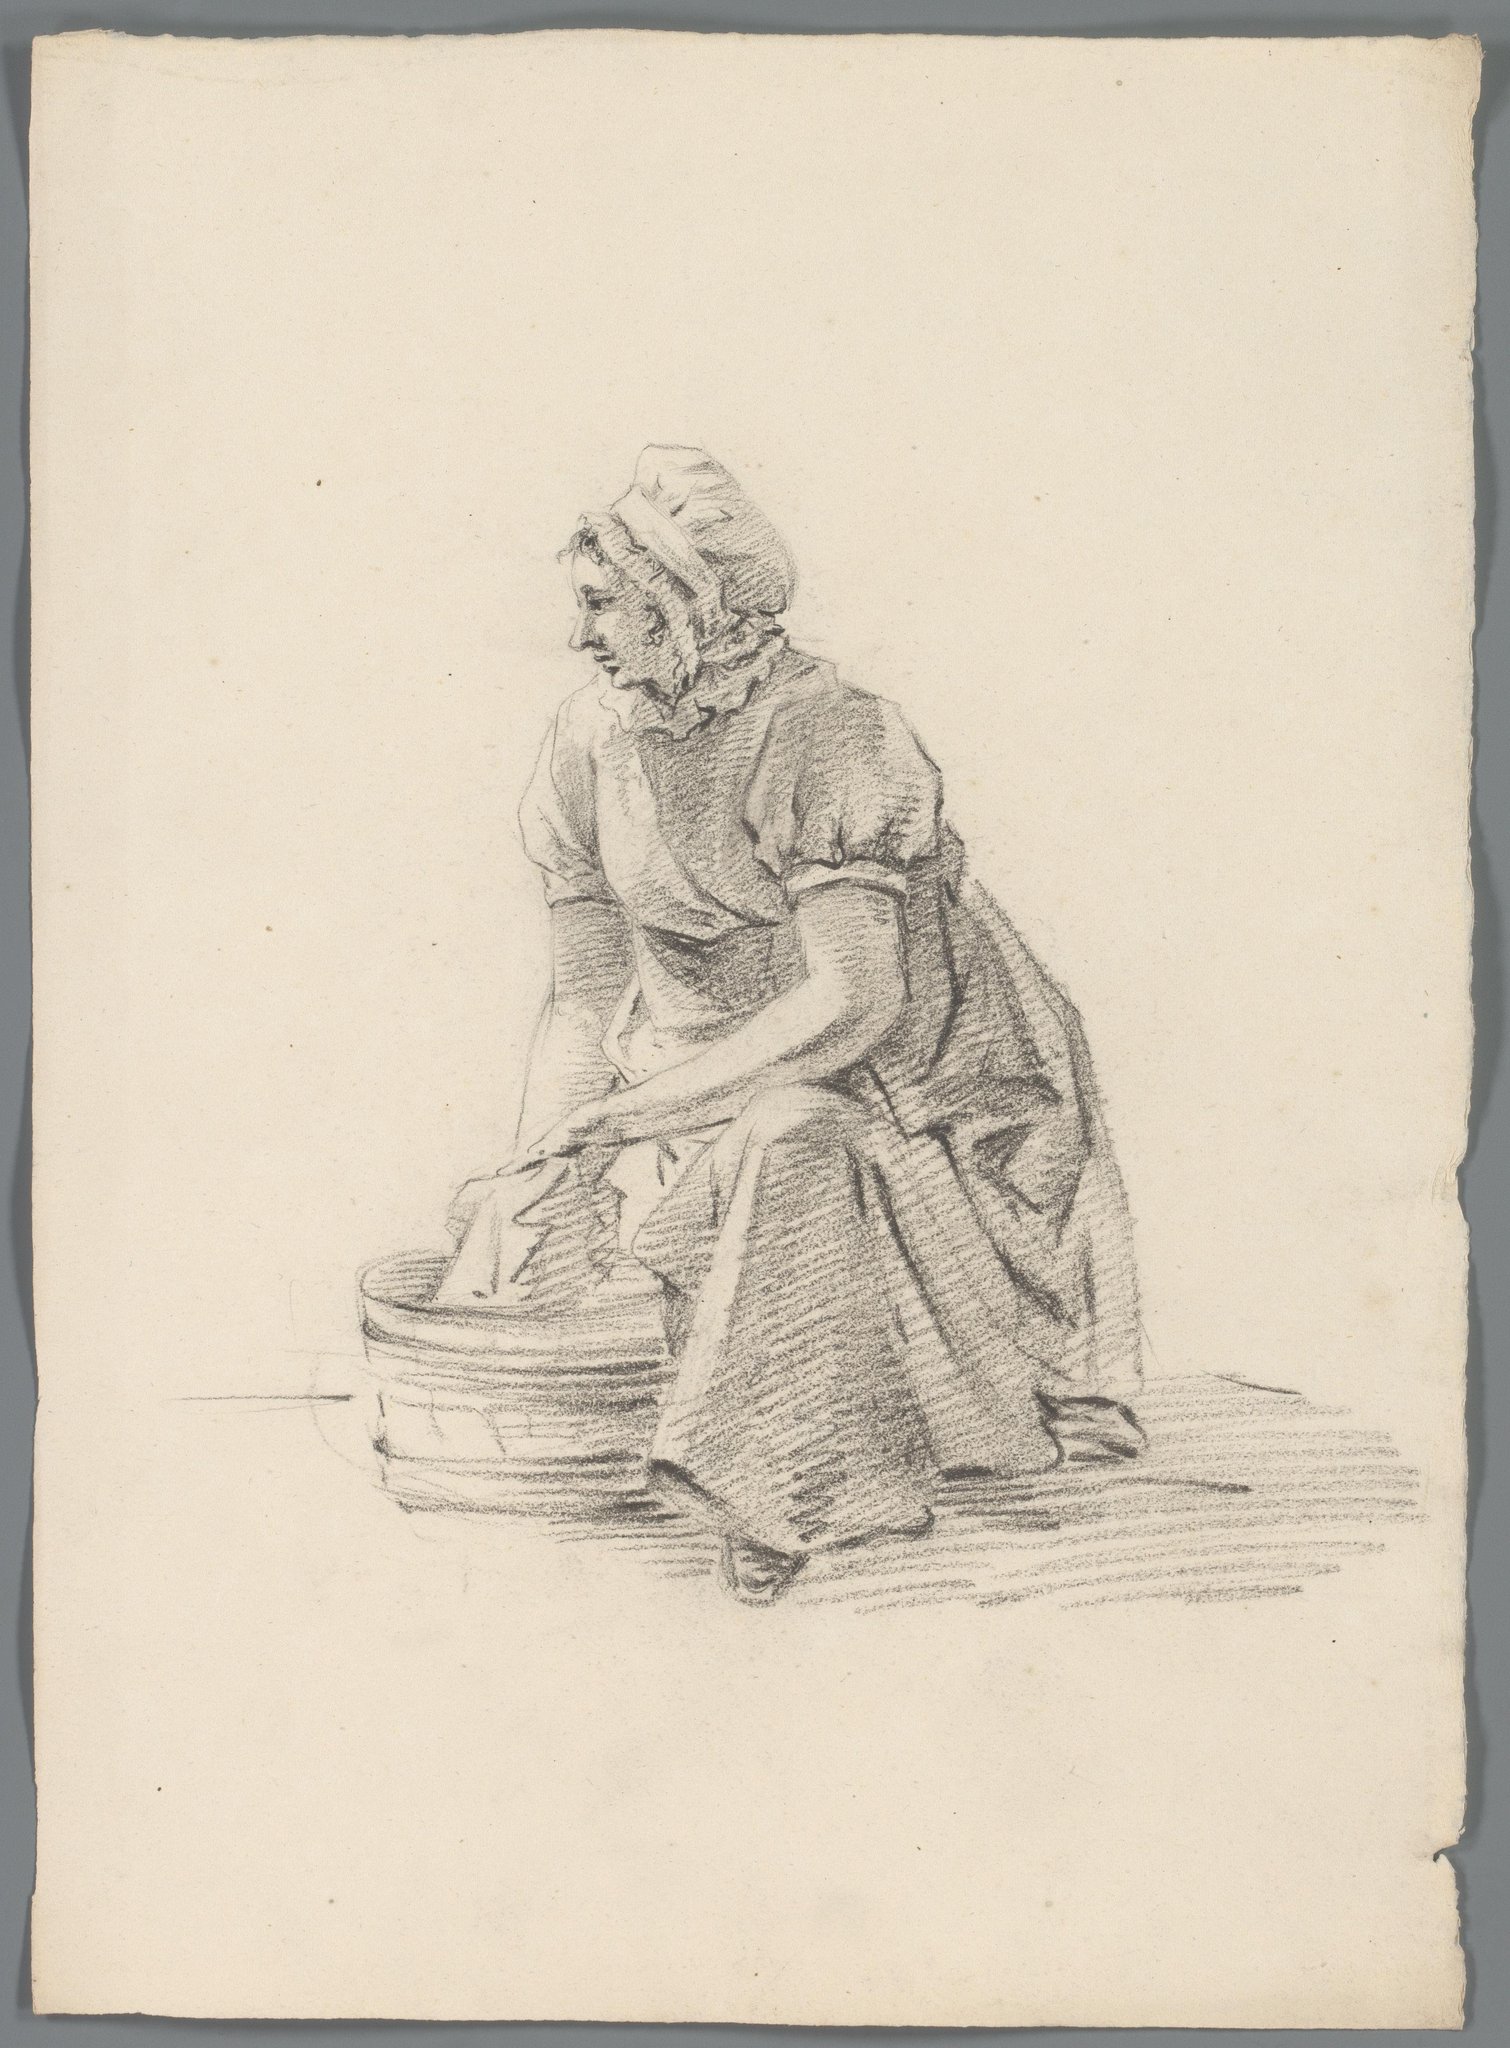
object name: drawing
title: Gehurkte vrouw naast een wastobbe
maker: Anonymous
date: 1820-1830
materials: chalk, paper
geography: the hague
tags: adult woman, kneeling figure - aa - female human figure, household chores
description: Tekeningen waarschijnlijk ontstaan bij het Haagse kunstgenootschap ‘Tot Nut der Tekenkunst’, waar twee keer per week tekenavonden werden georganiseerd met geklede modellen.